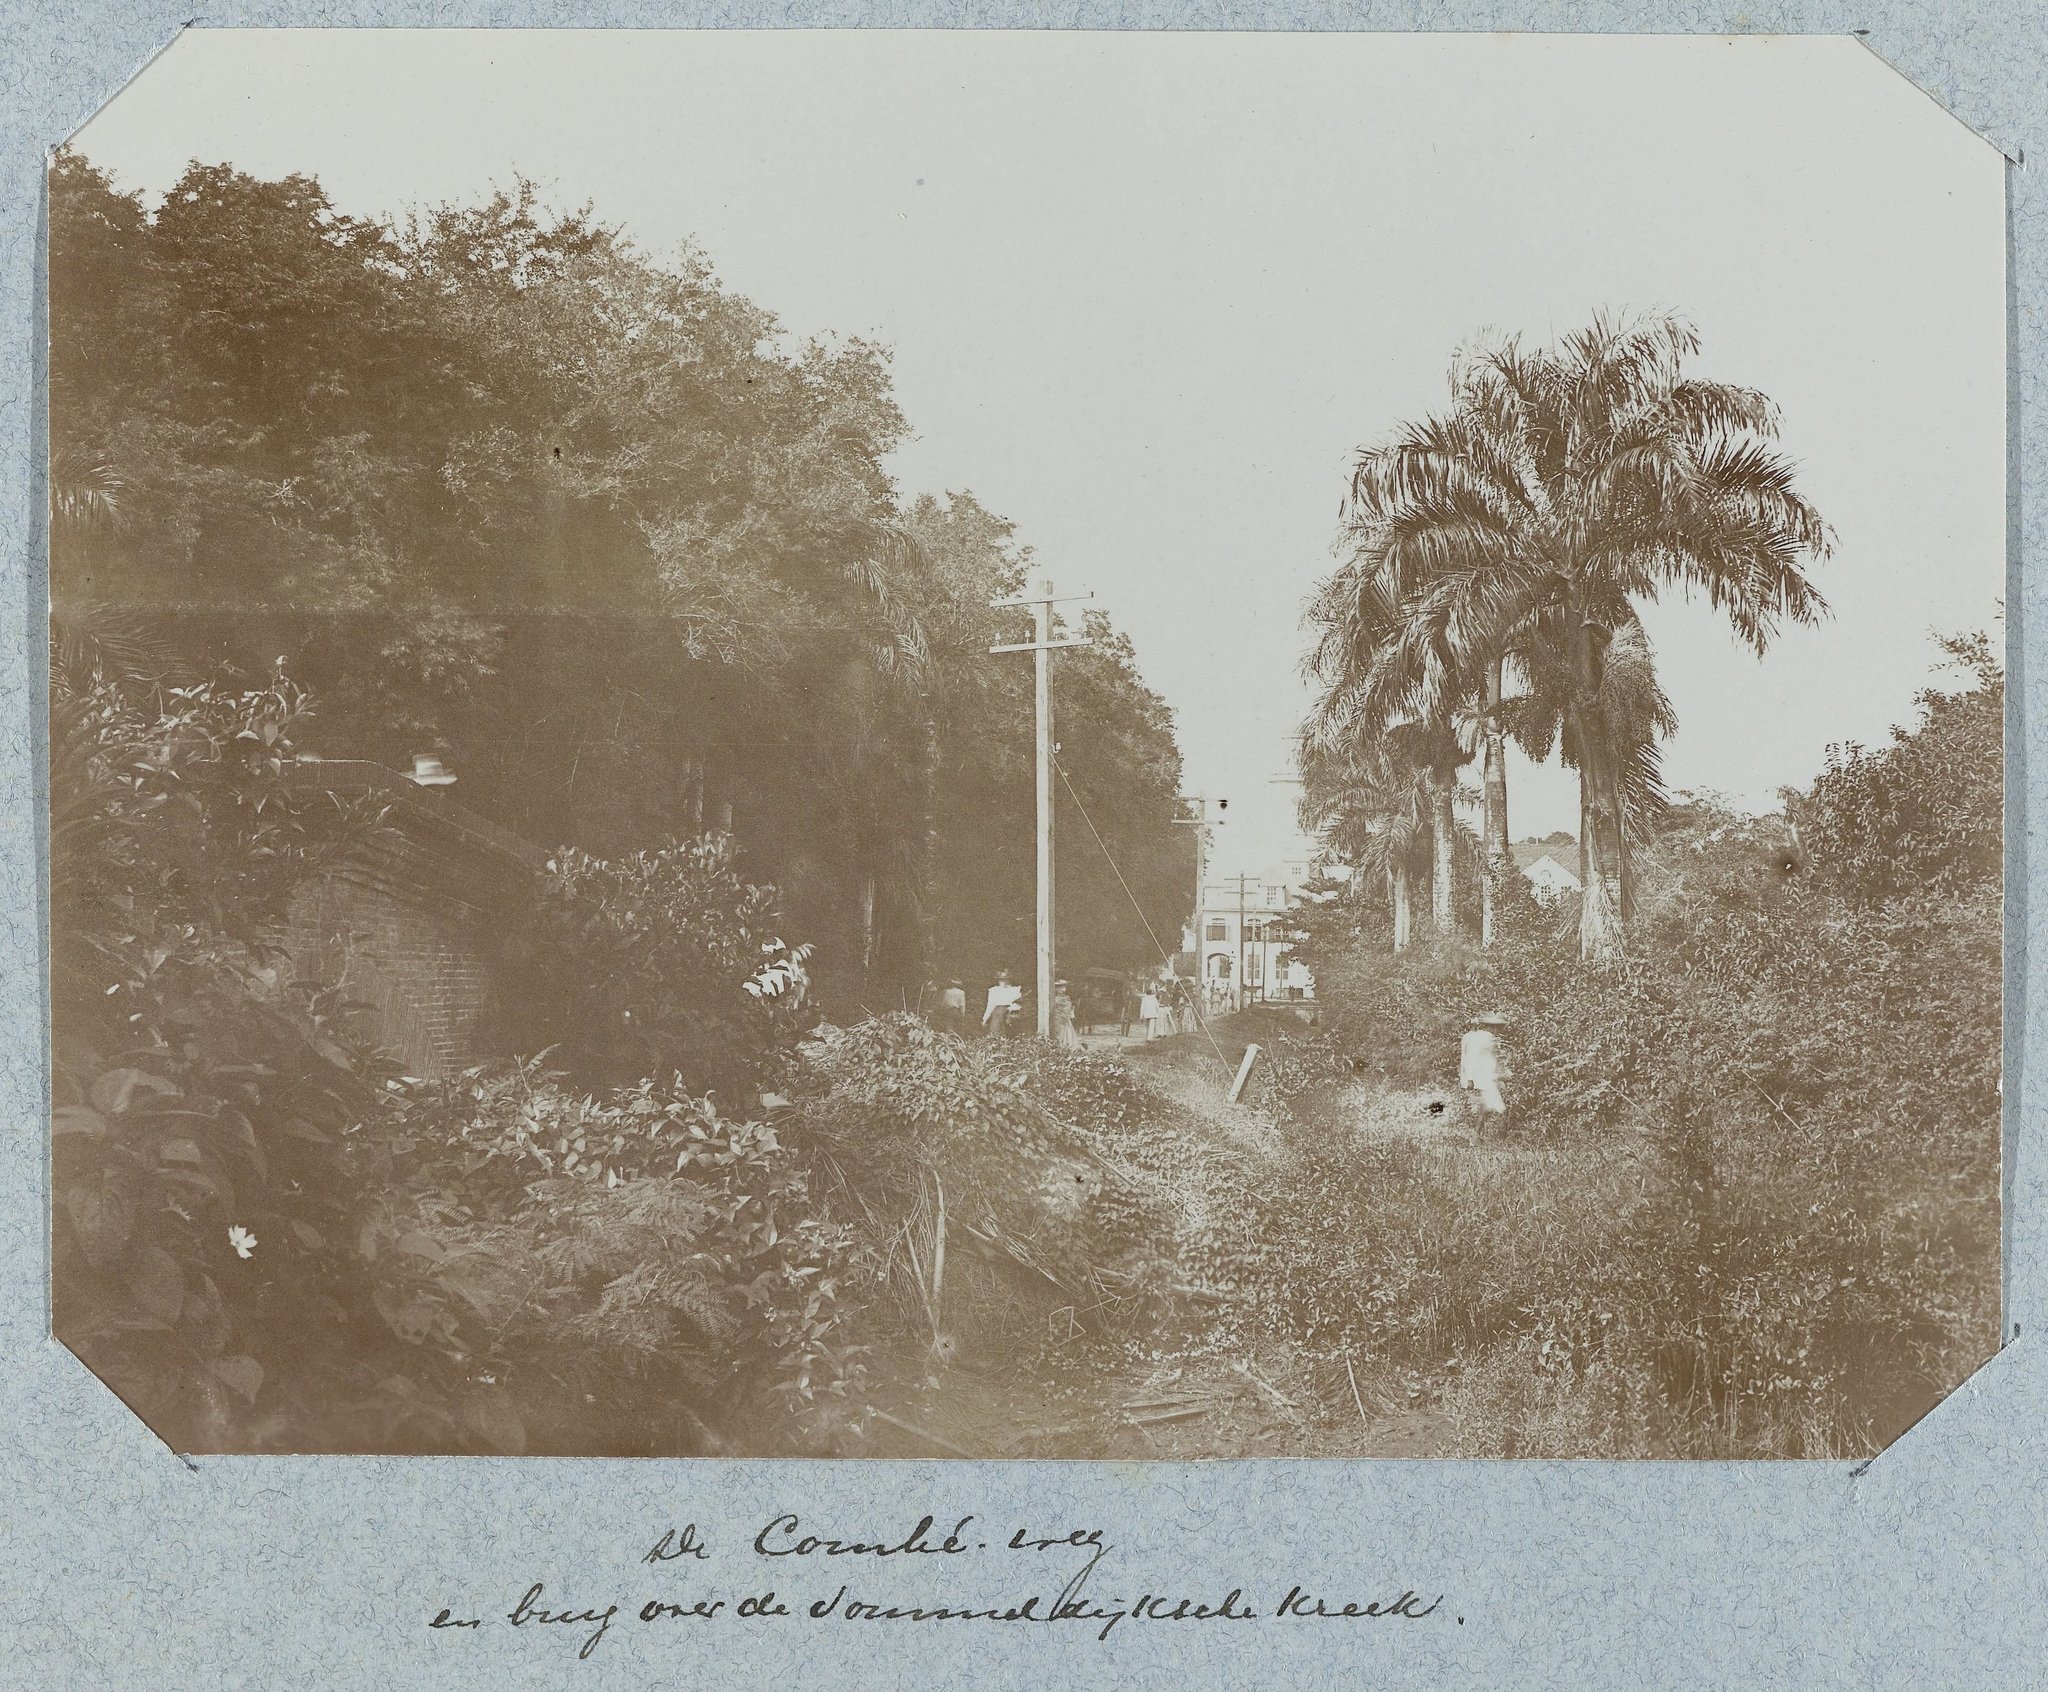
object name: photograph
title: De Combé-weg en brug over de Sommeldijksche kreek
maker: théodore van lelyveld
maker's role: painter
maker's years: 1867-1954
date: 1895-1898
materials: photographic support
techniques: collodion silver print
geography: suriname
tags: lane, alley (+ city(-scape) with figures, staffage)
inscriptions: inscription: ‘De Combé-weg en brug over de Sommeldijksche kreek.’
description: Gezicht op de Combé-weg en de brug bij de Sommelsdijkse kreek, te Paramaribo. Fotoafdruk in een fotoalbum van Théodore van Lelyveld over Suriname uit 1895-1898.